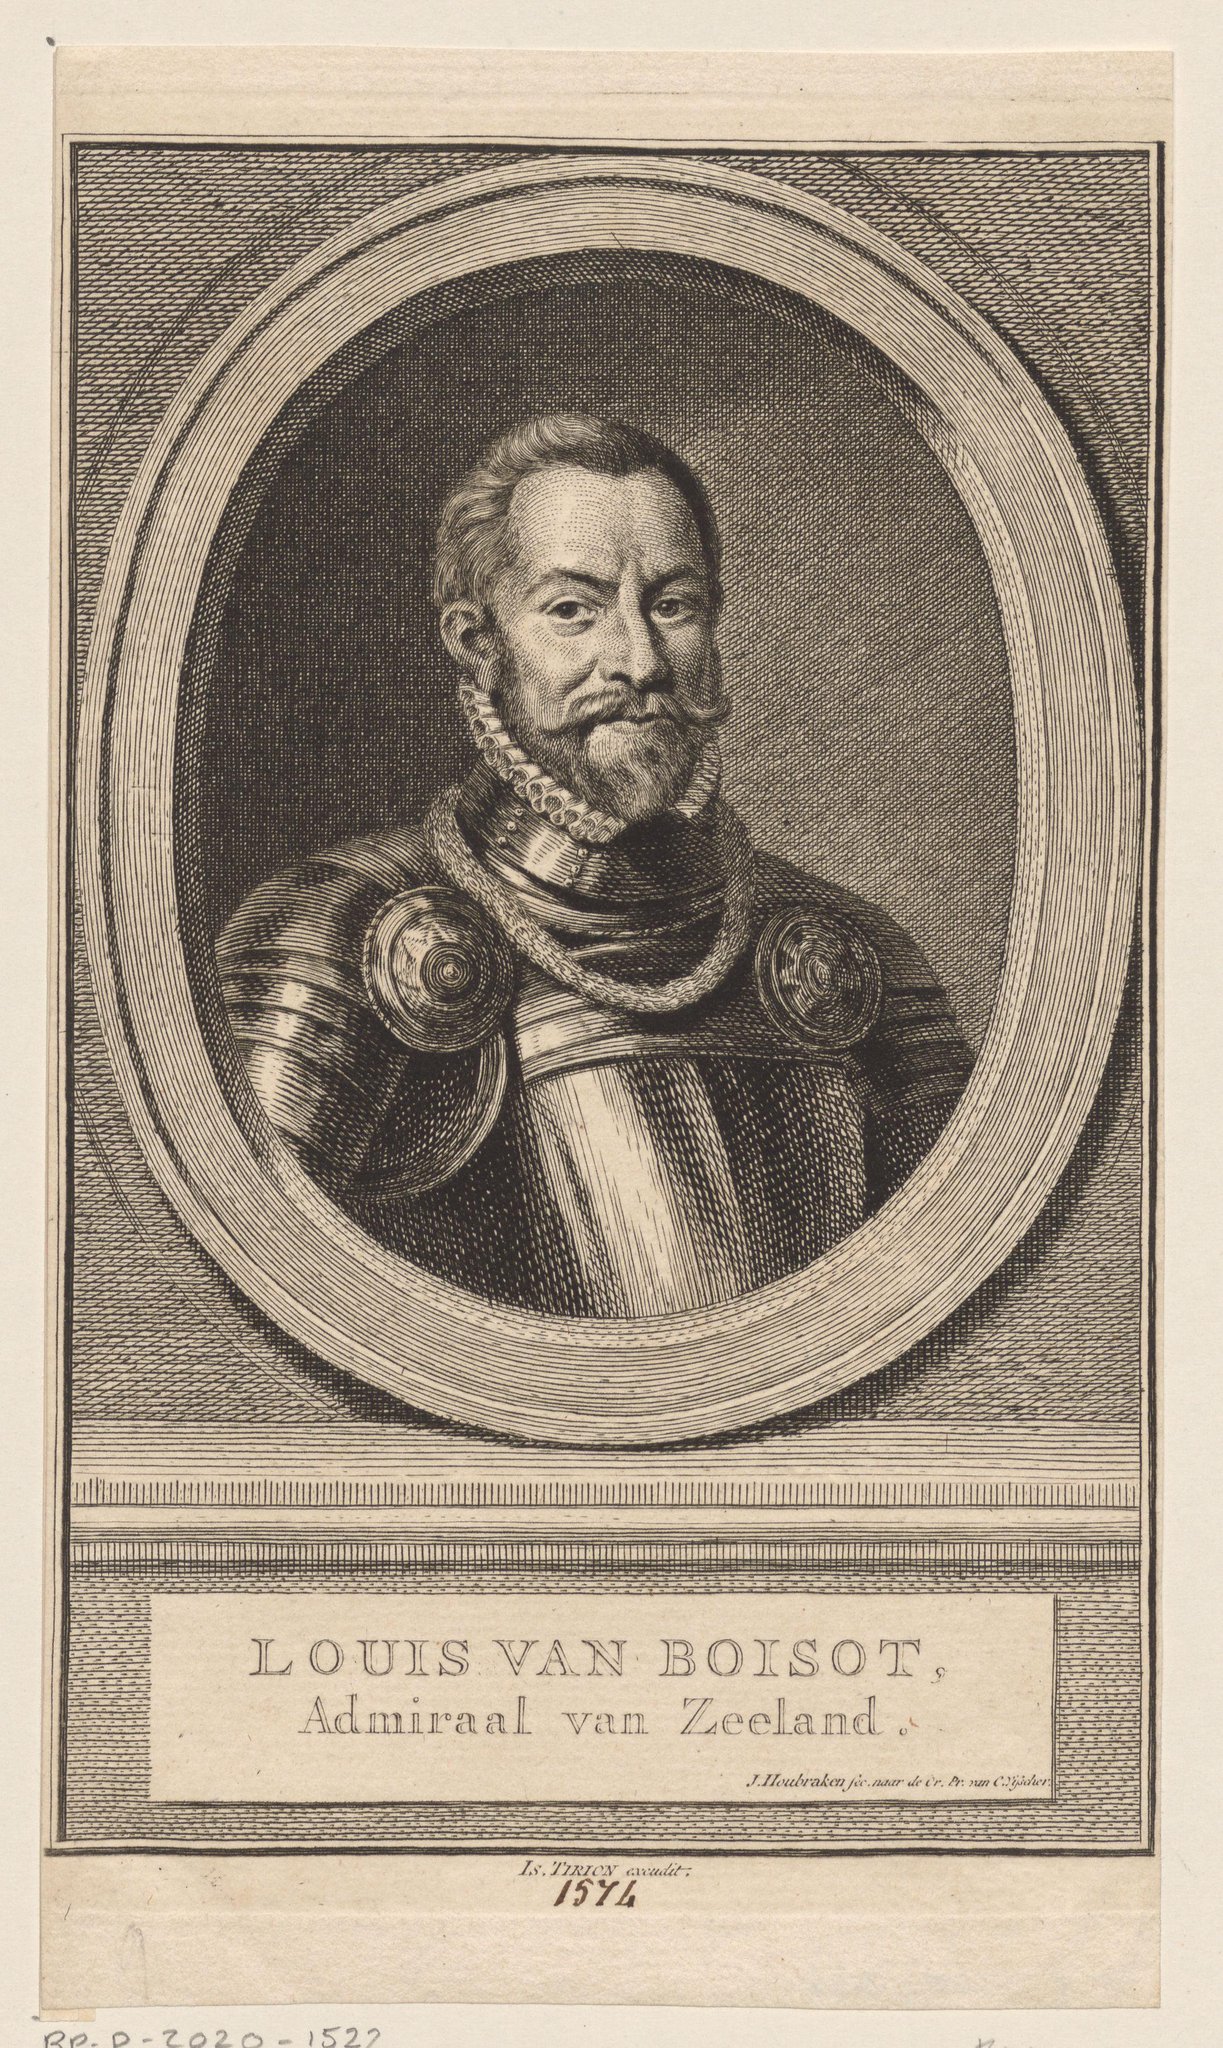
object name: print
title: Portret van Louis de Boisot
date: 1749-1759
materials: paper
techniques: engraving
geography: amsterdam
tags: brussels, historical persons, officer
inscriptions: inscription: ‘1574’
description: Prent voor het eerst verschenen in: Wagenaar, Jan. Vaderlandsche historie, vervattende de geschiedenissen der nu Vereenigde Nederlanden, inzonderheid die van Holland (...). 21 dln. Amsterdam: Isaak Tirion, 1749-1759, dl. 6. Prent ook gebruikt in latere edities van dit werk.